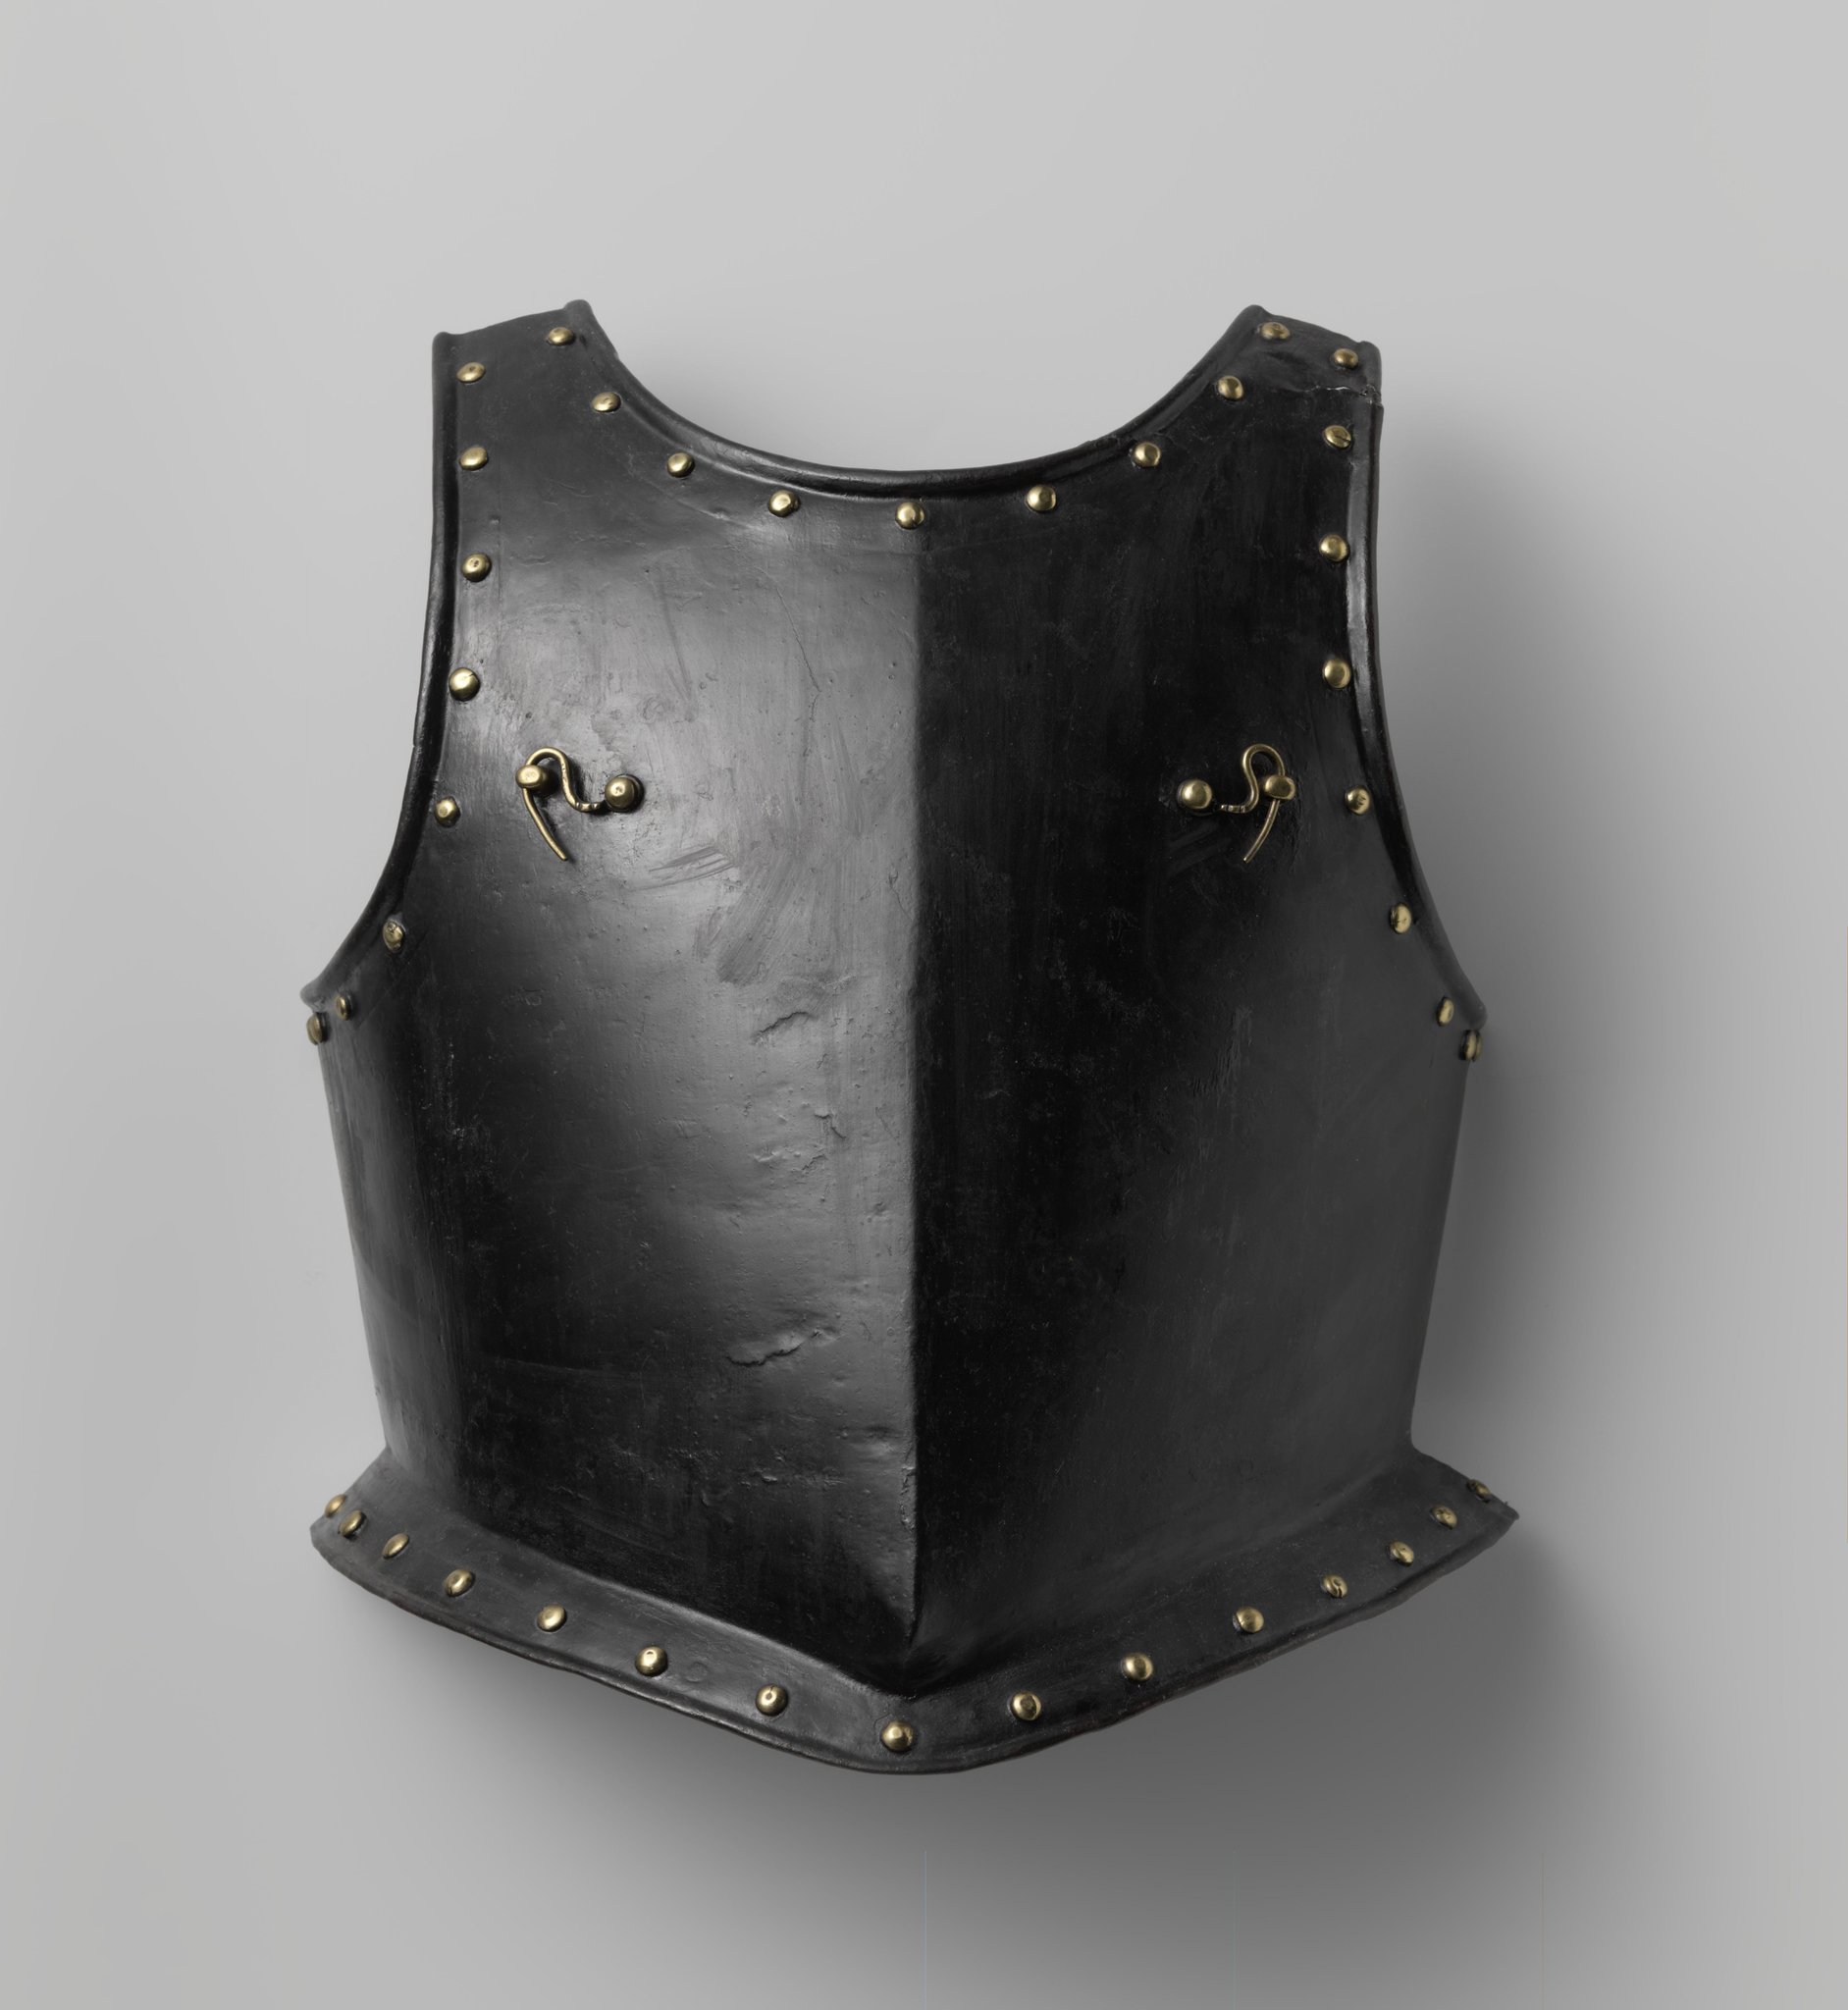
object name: harnasonderdeel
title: Borstplaat van zwart geverfd ruiterharnas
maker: Anonymous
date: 1599-1699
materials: copper, iron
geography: netherlands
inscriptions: : ‘1134’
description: Borstplaat, ijzer, zwart geverfd, uit één plaat gemaakt, de halsuitsnijding en armuitsnijdingen hebben een omgeflenste rand. Ter hoogte van de armuitsnijdingen twee geelkoperen haken met met knoppen waar de gesp van de rugplaat aan bevestigd kan worden. Rondom deze randen geelkoperen klinknagels. Verticale middengraat die eindigt in een kleine uitstulping vlak boven de buikkraag. De rand van de buikkraag is omgeflenst en heeft rondom geelkoperen klinknagels. Binnenzijde is zwart geverfd.